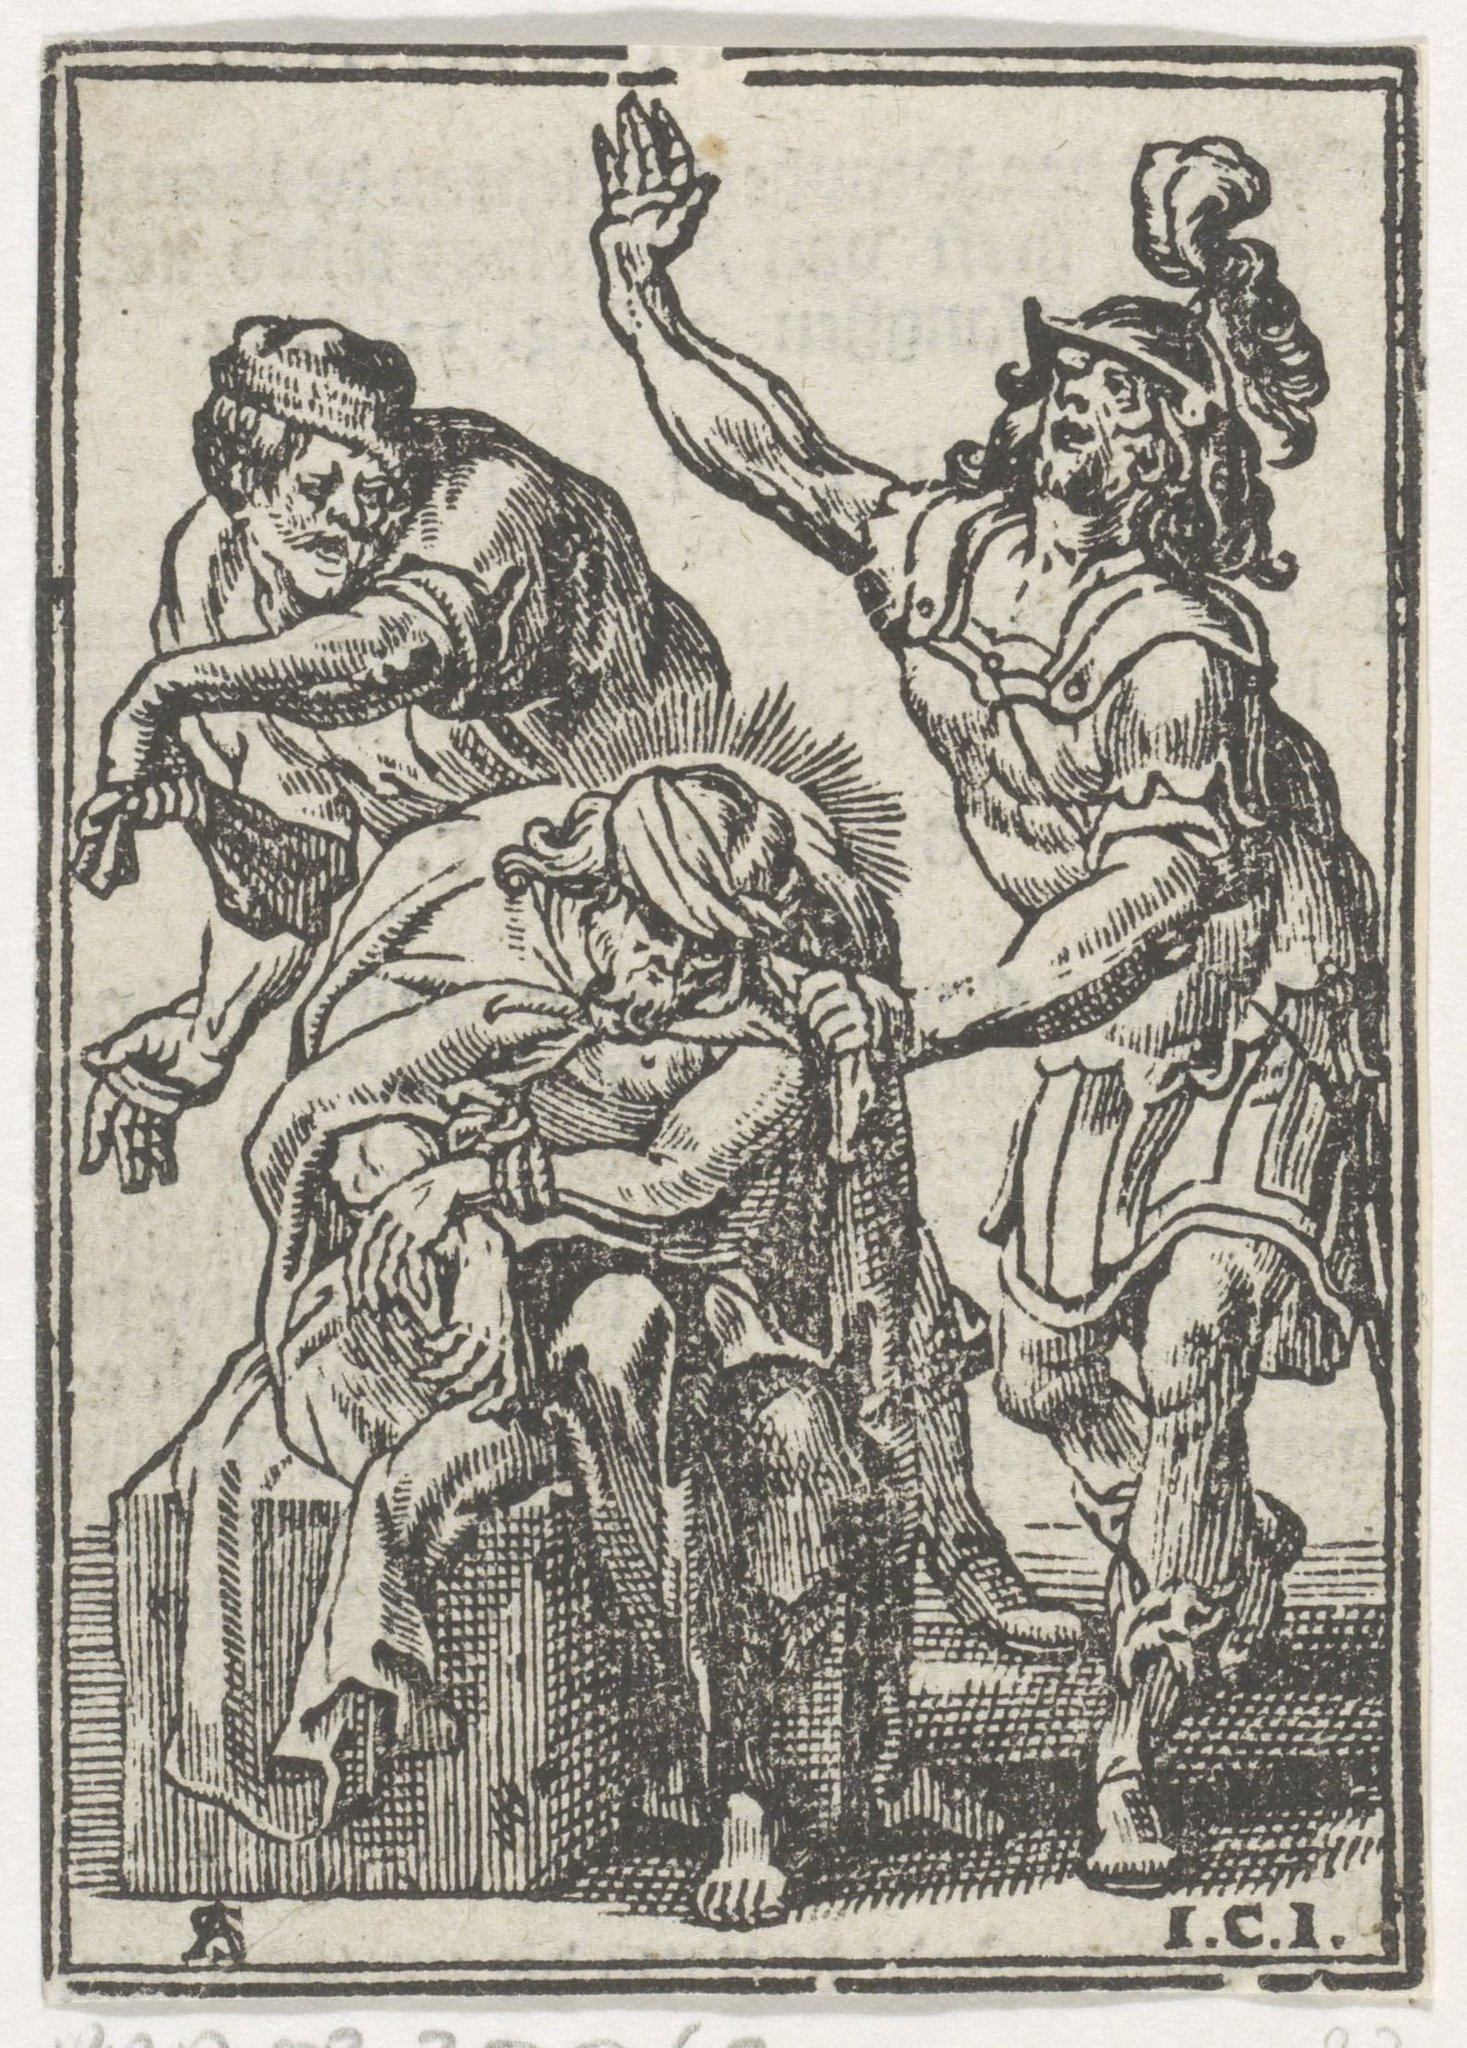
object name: book illustration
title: Bespotting van Christus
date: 1649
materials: paper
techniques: letterpress printing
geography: antwerp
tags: mockings of christ, who may be blindfolded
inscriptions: collector's mark: Lugt 2228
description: Prent uit: Andries, Judocus. Perpetua crux sive passio Jesu Christi. Antwerpen: Cornelis Woons, 1649.